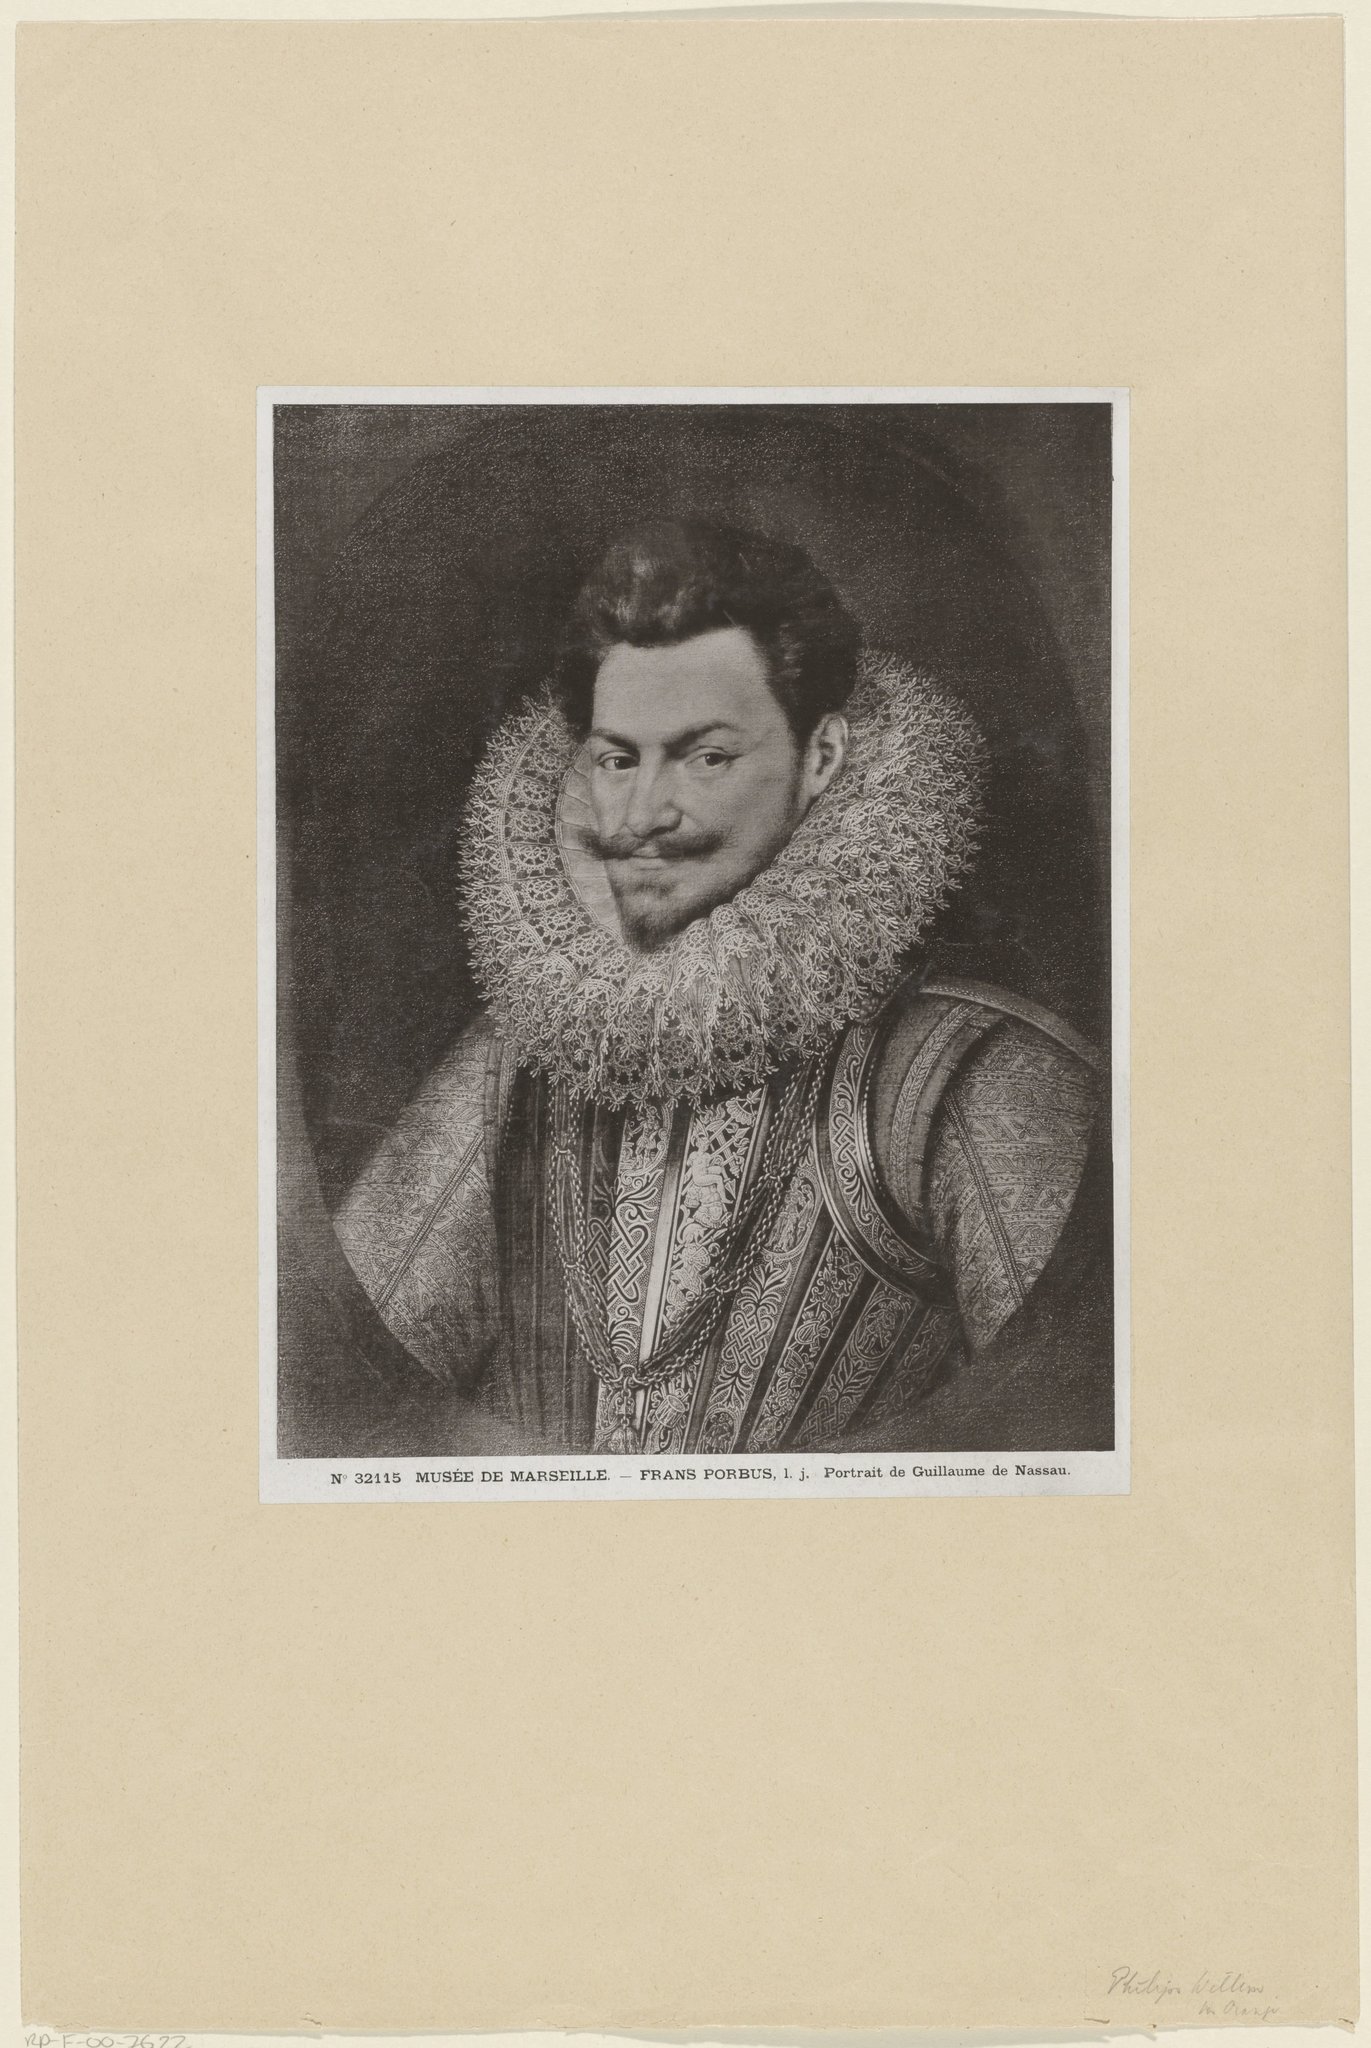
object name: photograph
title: Portret van Filips Willem, prins van Oranje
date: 1850-1930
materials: photographic support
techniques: photography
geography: netherlands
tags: filips willem (prins van oranje), knighthood order of the golden fleece - insignia of a knighthood order, e.g.: badge, chain (with name of order)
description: De hier vermelde titel verwijst naar de hoogst verkregen titel van de geportretteerde, niet per se naar de titel die de geportretteerde op deze voorstelling draagt.